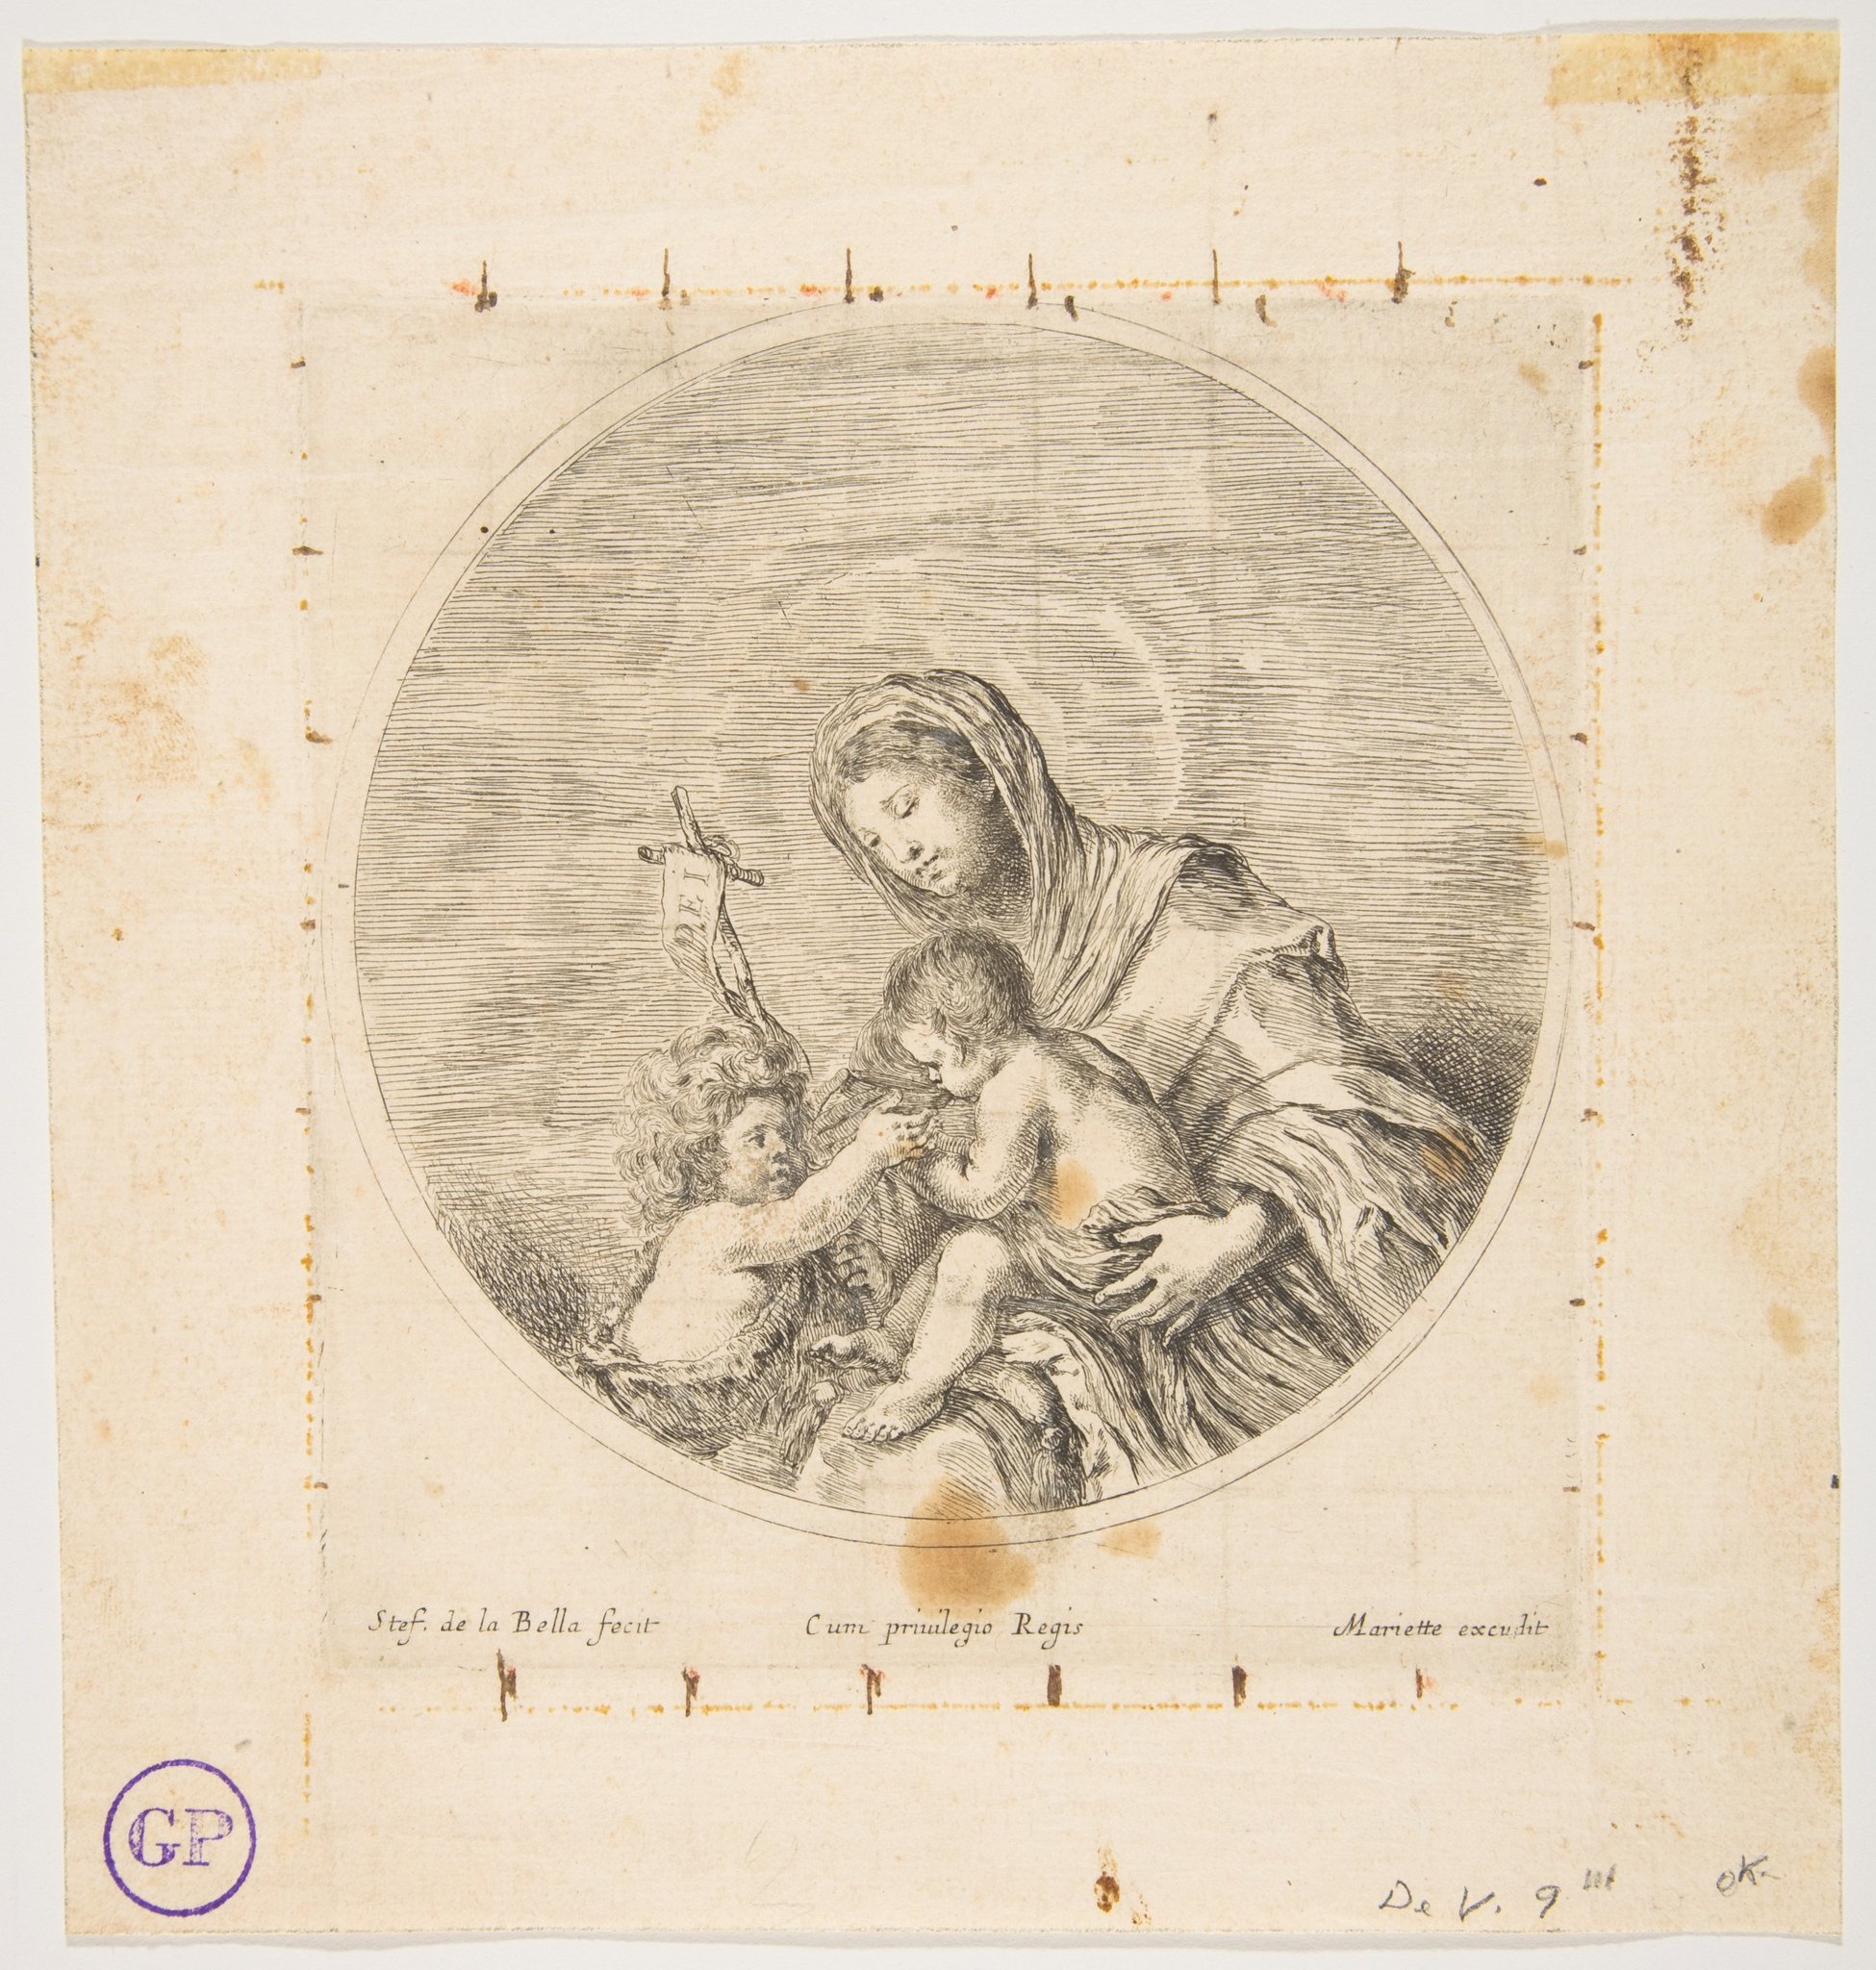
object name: print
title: The Virgin and Child with Saint John, a round composition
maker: stefano della bella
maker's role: artist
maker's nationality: italian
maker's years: 1610-1664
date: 1641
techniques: etching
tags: madonna and child,saint john the baptist